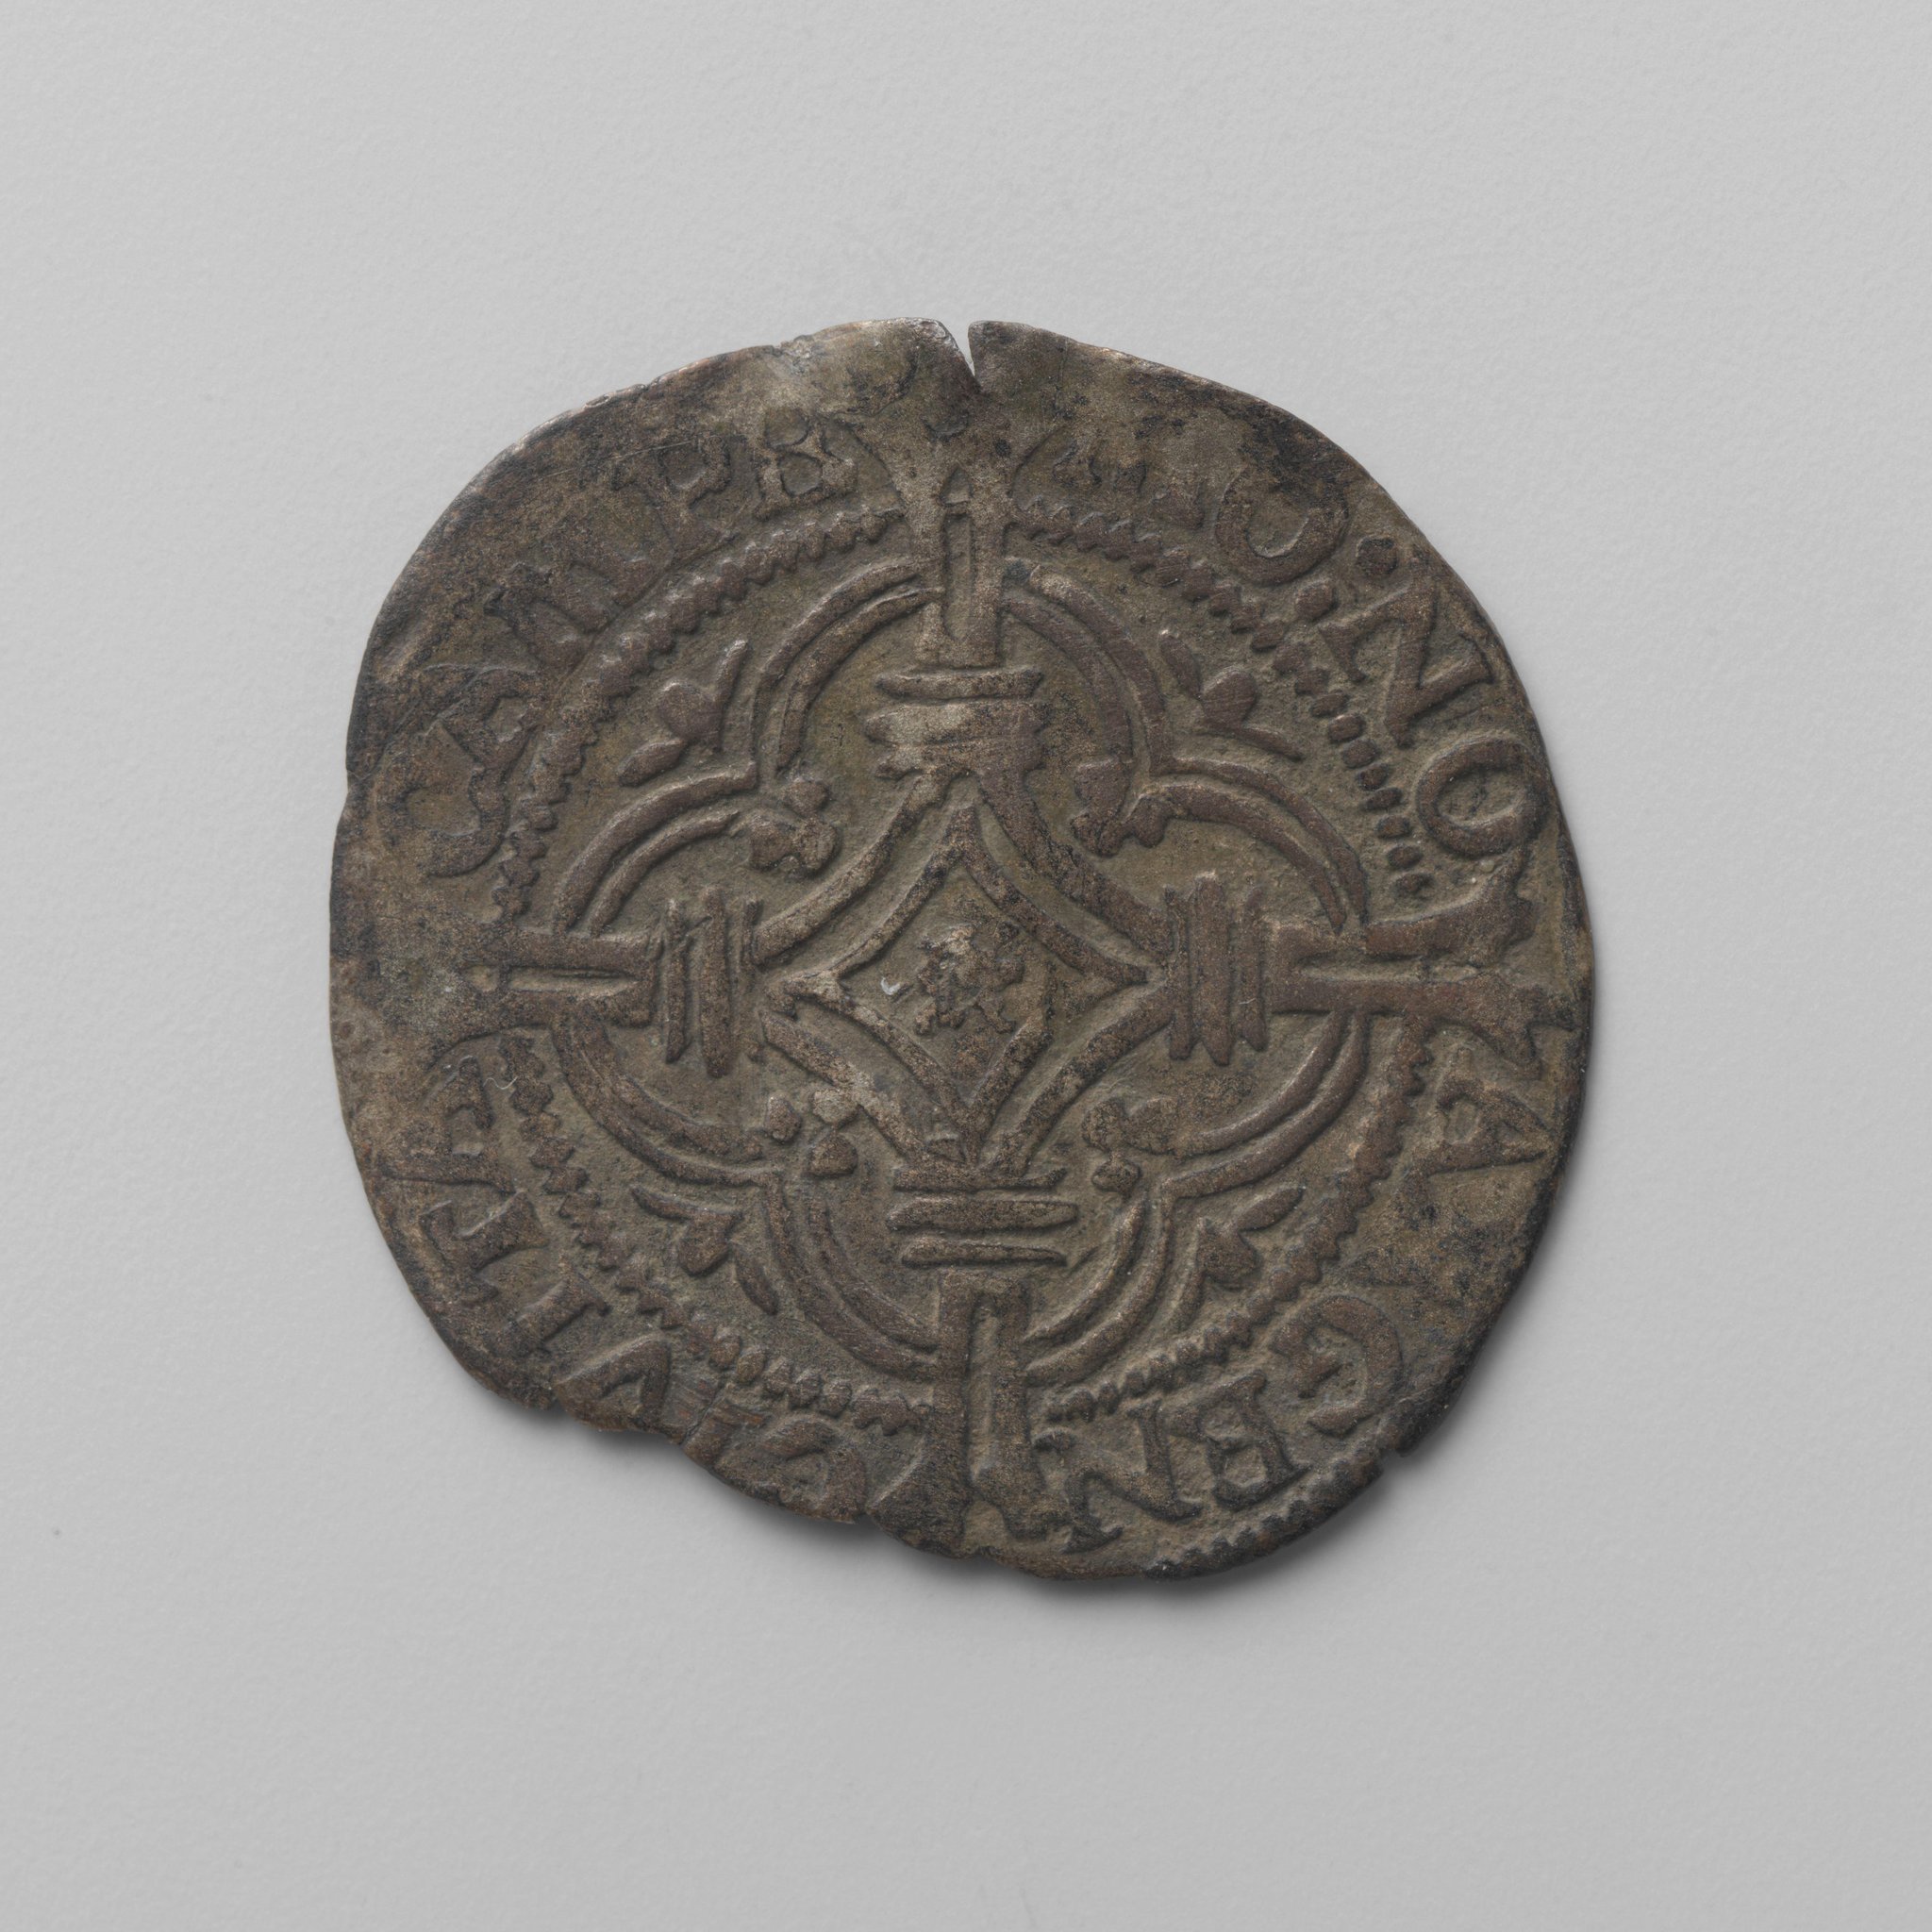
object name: coin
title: Stuiver van Kampen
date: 1590-1610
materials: silver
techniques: striking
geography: kampen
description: Zilveren munt. Voorzijde: tussen waarde-aanduiding I S gekroond vereenvoudigd Spaans wapenschild. Keerzijde: op dubbellijnige vierpas lang gevoet kruis met in het centrum een rooosje.